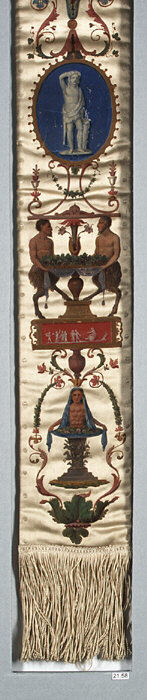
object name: bellpull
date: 1804-1814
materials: silk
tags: satyrs